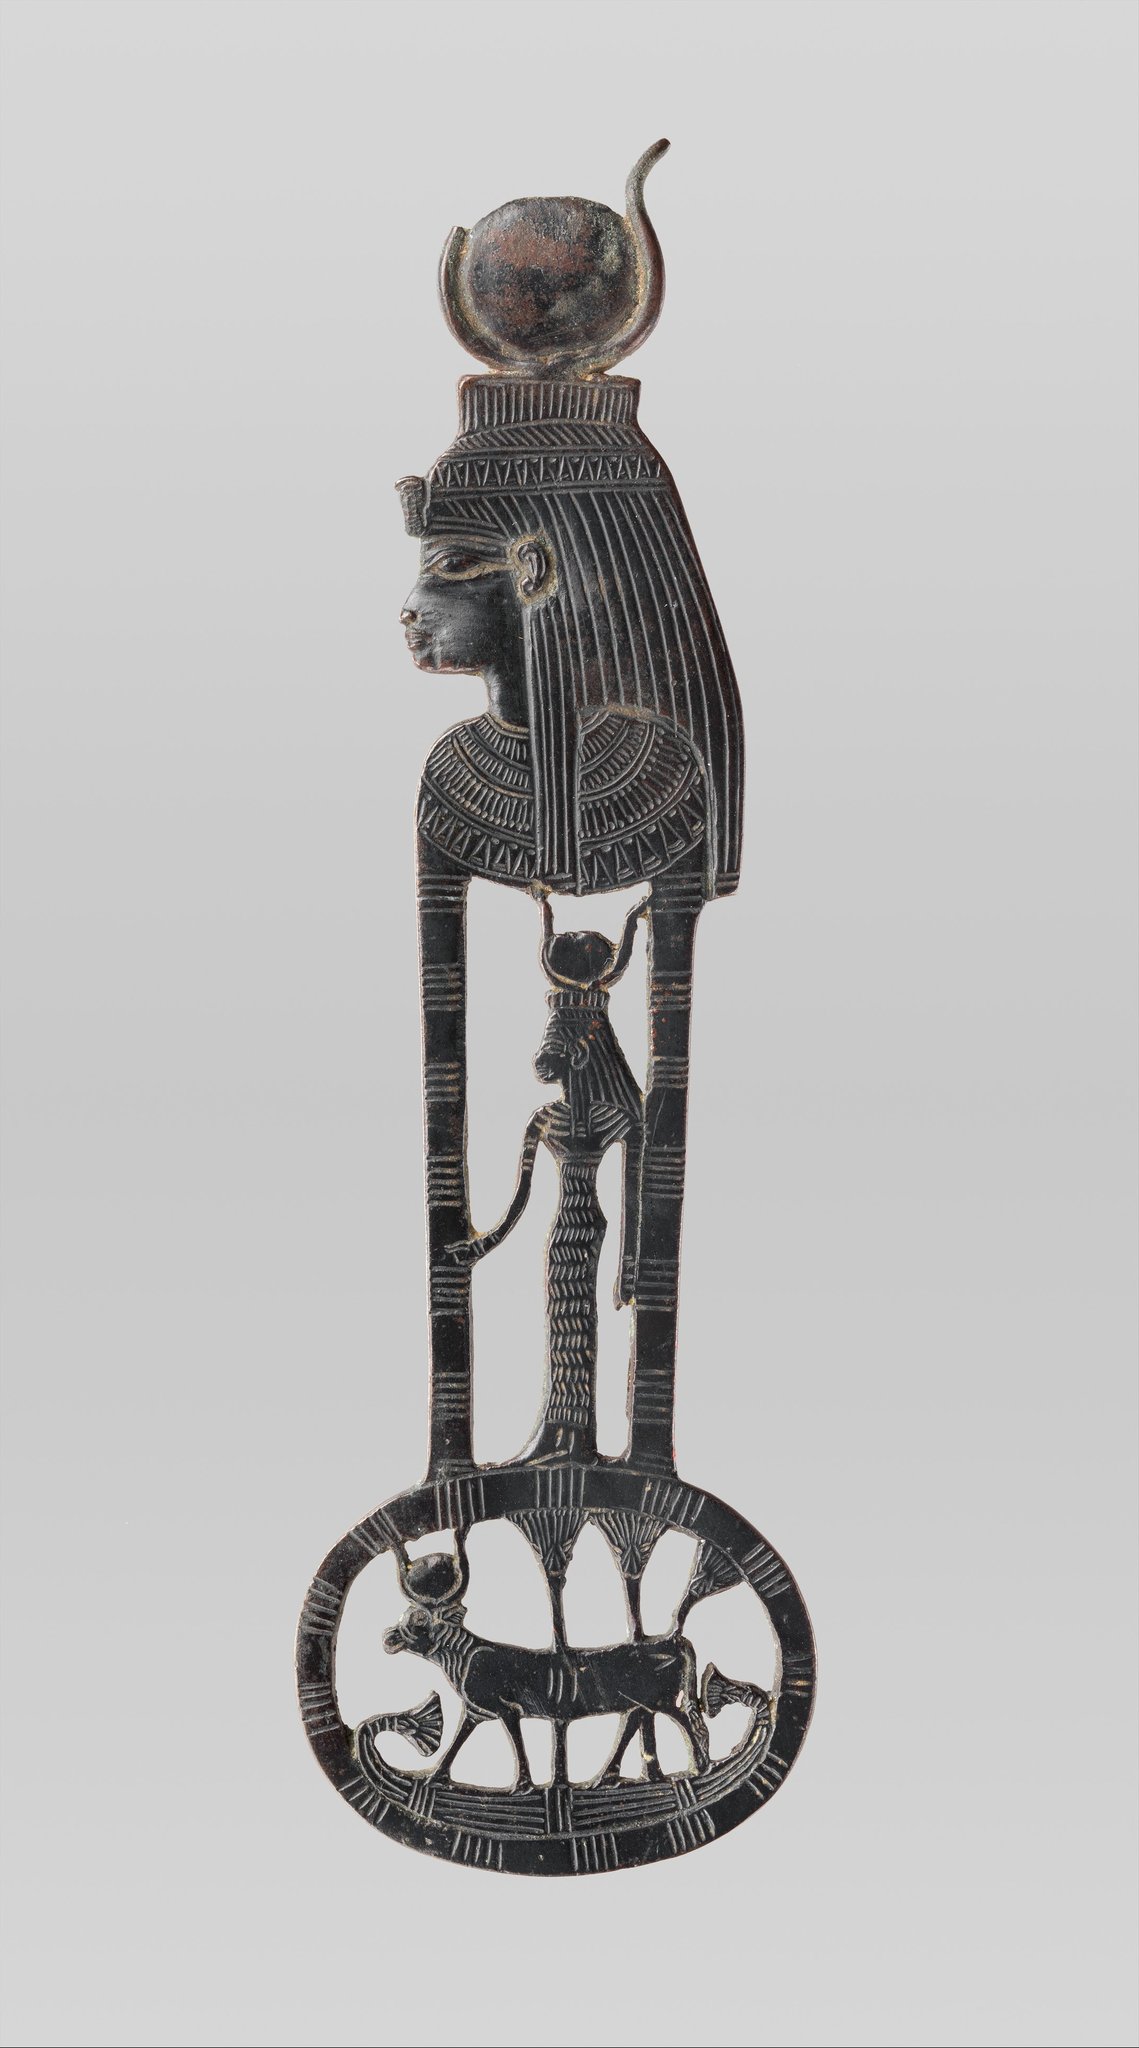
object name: menat, hathor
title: Menat counterpoise with figures of Hathor as a woman and a cow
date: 1390-1352 BCE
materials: alloy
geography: egypt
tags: hathor,cows